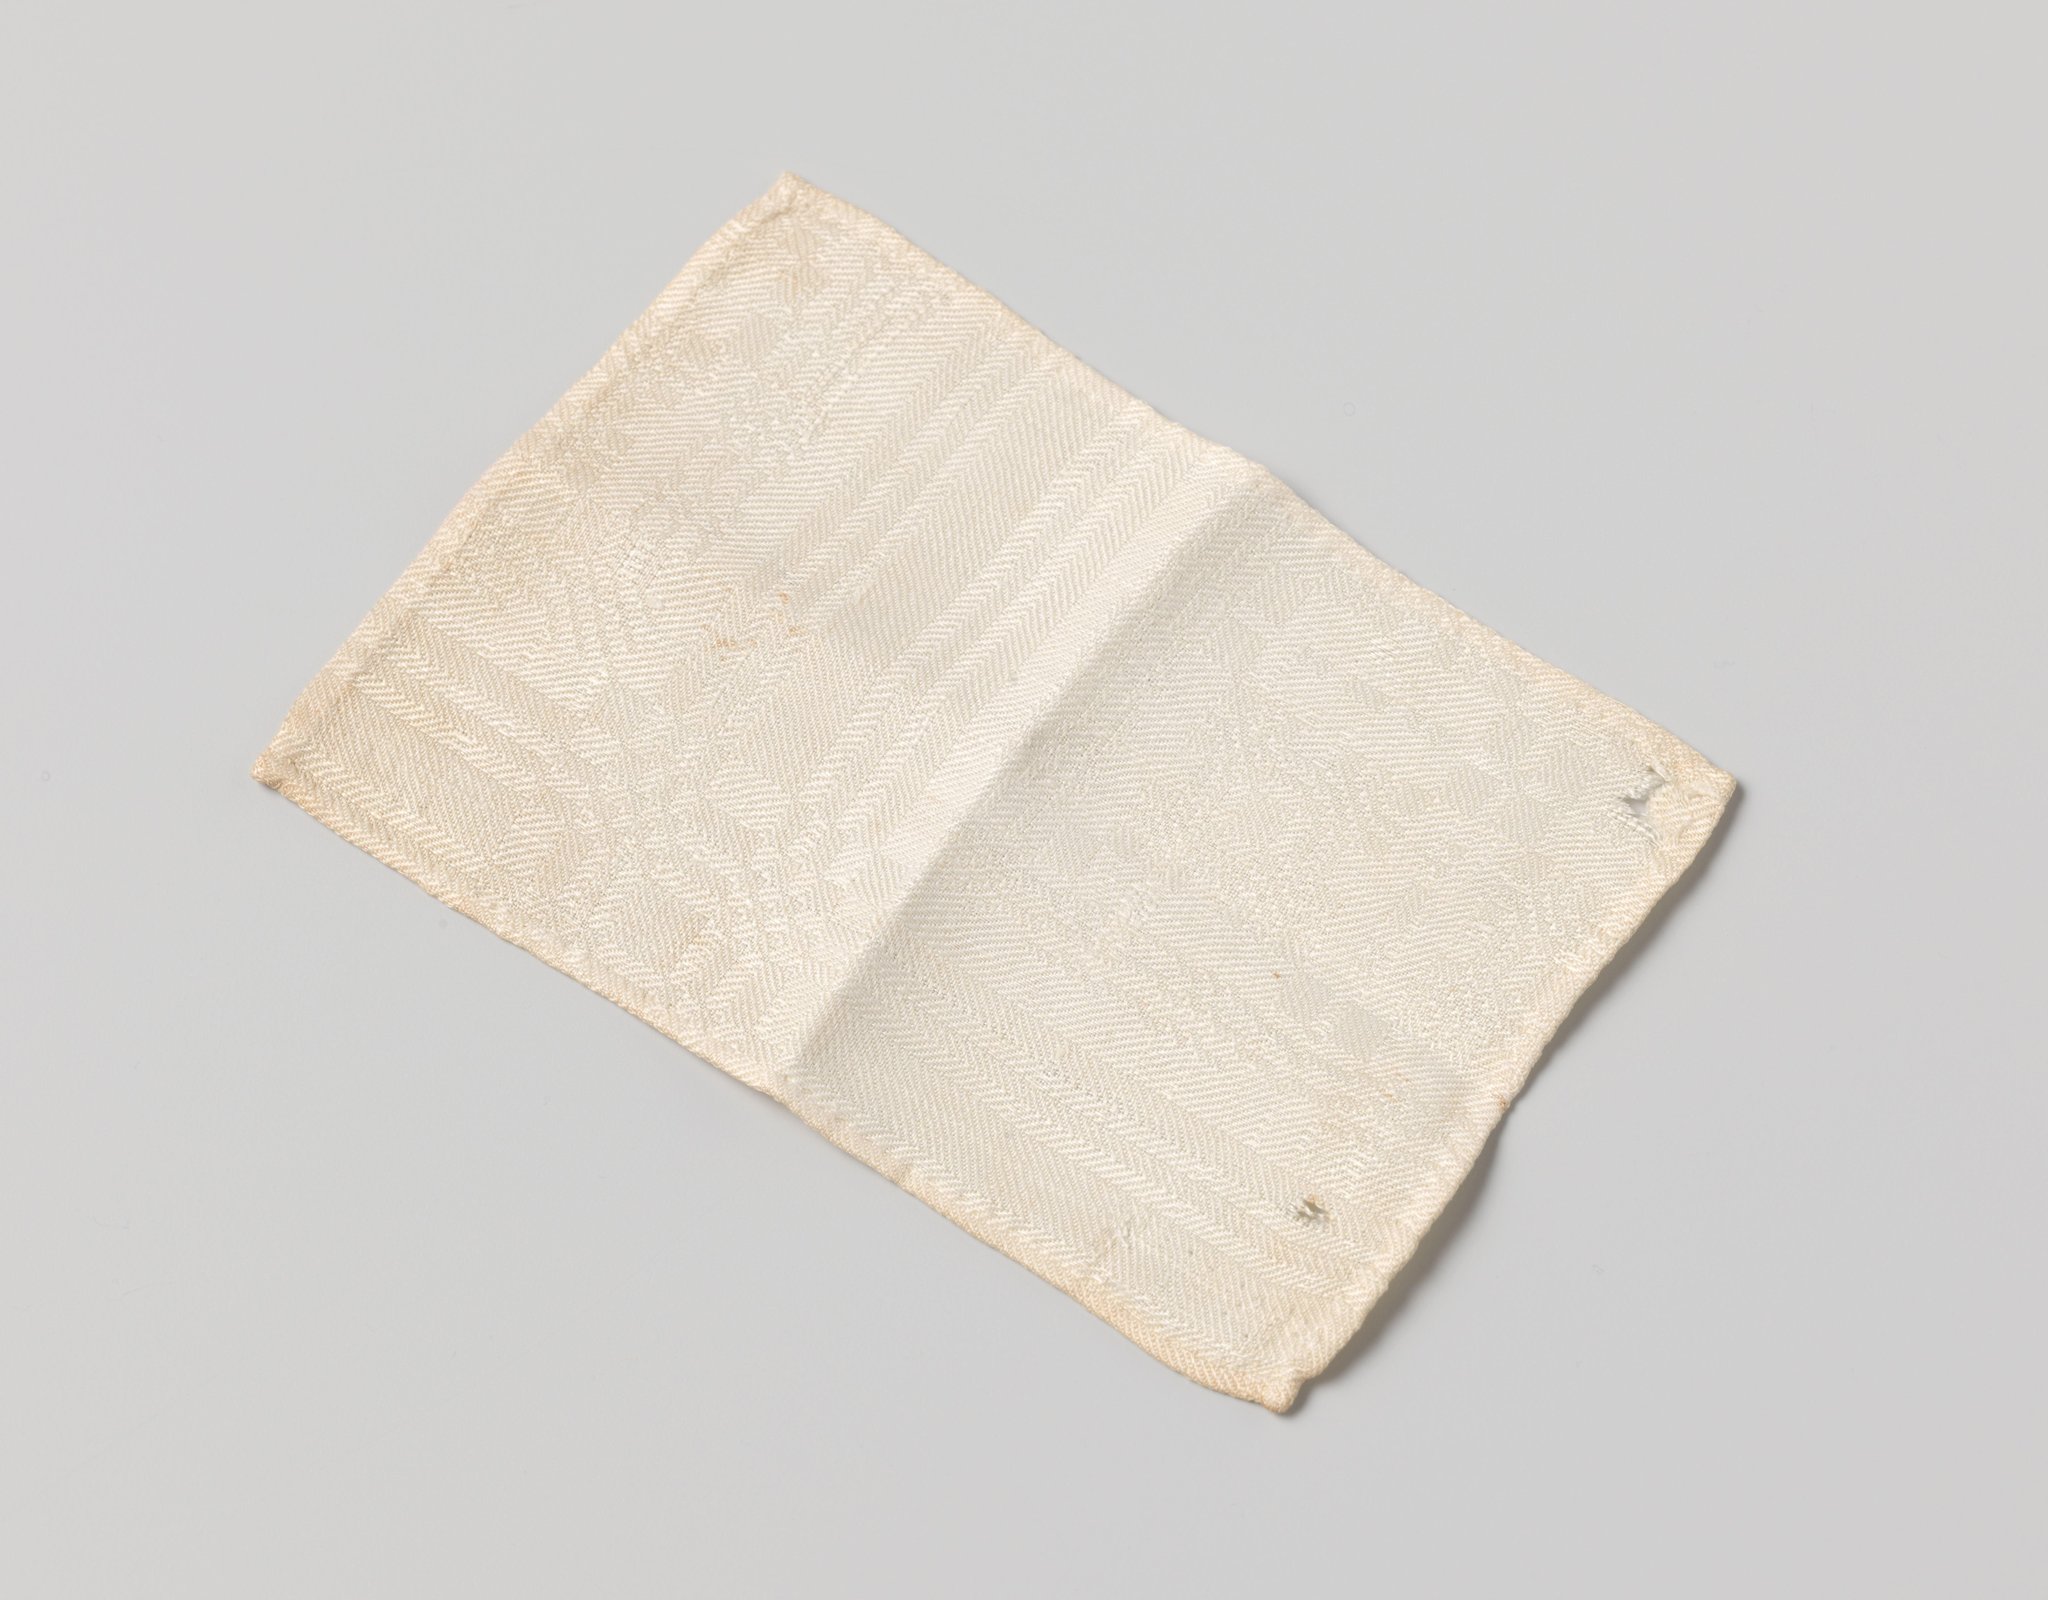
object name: miniature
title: Servet, met ingeweven pellenpatroon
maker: Anonymous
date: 1750-1800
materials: linen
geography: netherlands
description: Servet van linnen met pellenpatroon, geknipt uit grotere lap; aan vier zijden omgezoomd..